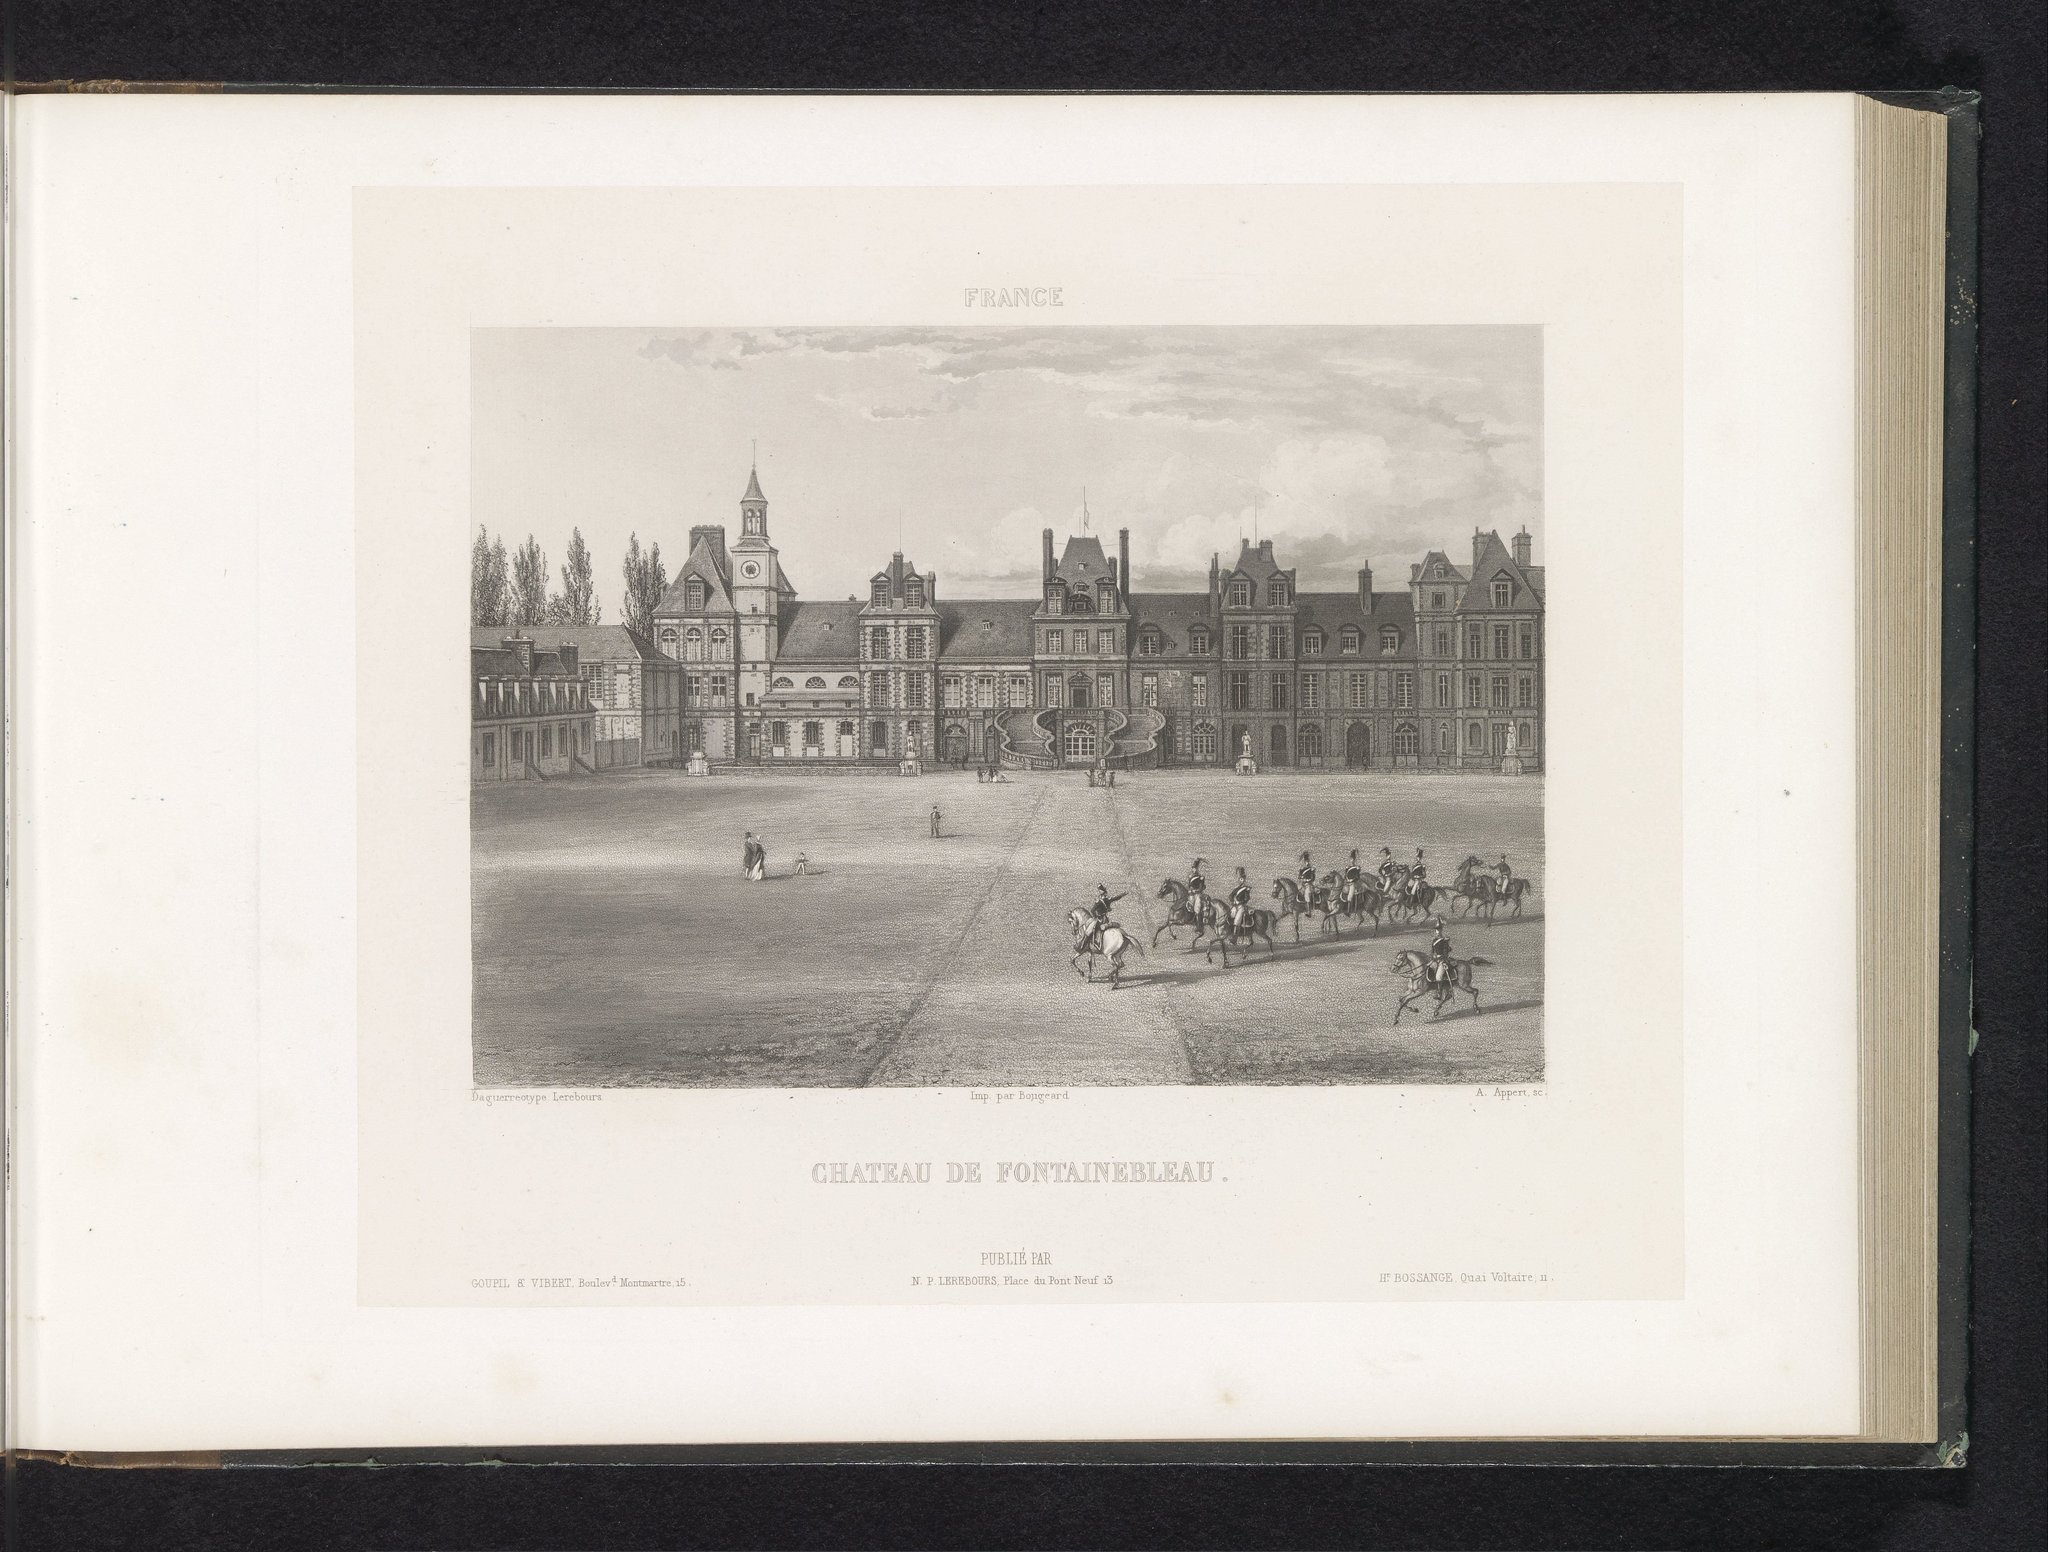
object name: page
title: Binnenhof van het Kasteel van Fontainebleau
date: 1839-1841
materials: paper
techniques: aquatint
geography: paris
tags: palace, façade (of house or building), inner court of palace or 'hôtel'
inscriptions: inscription: ‘Rittner & Goupil Boulevd Montmartre 15’, inscription: ‘Hr. Bossance Quai Voltaire 11’, inscription: ‘N.P. Lerebours Place du Pont Neuf 15’